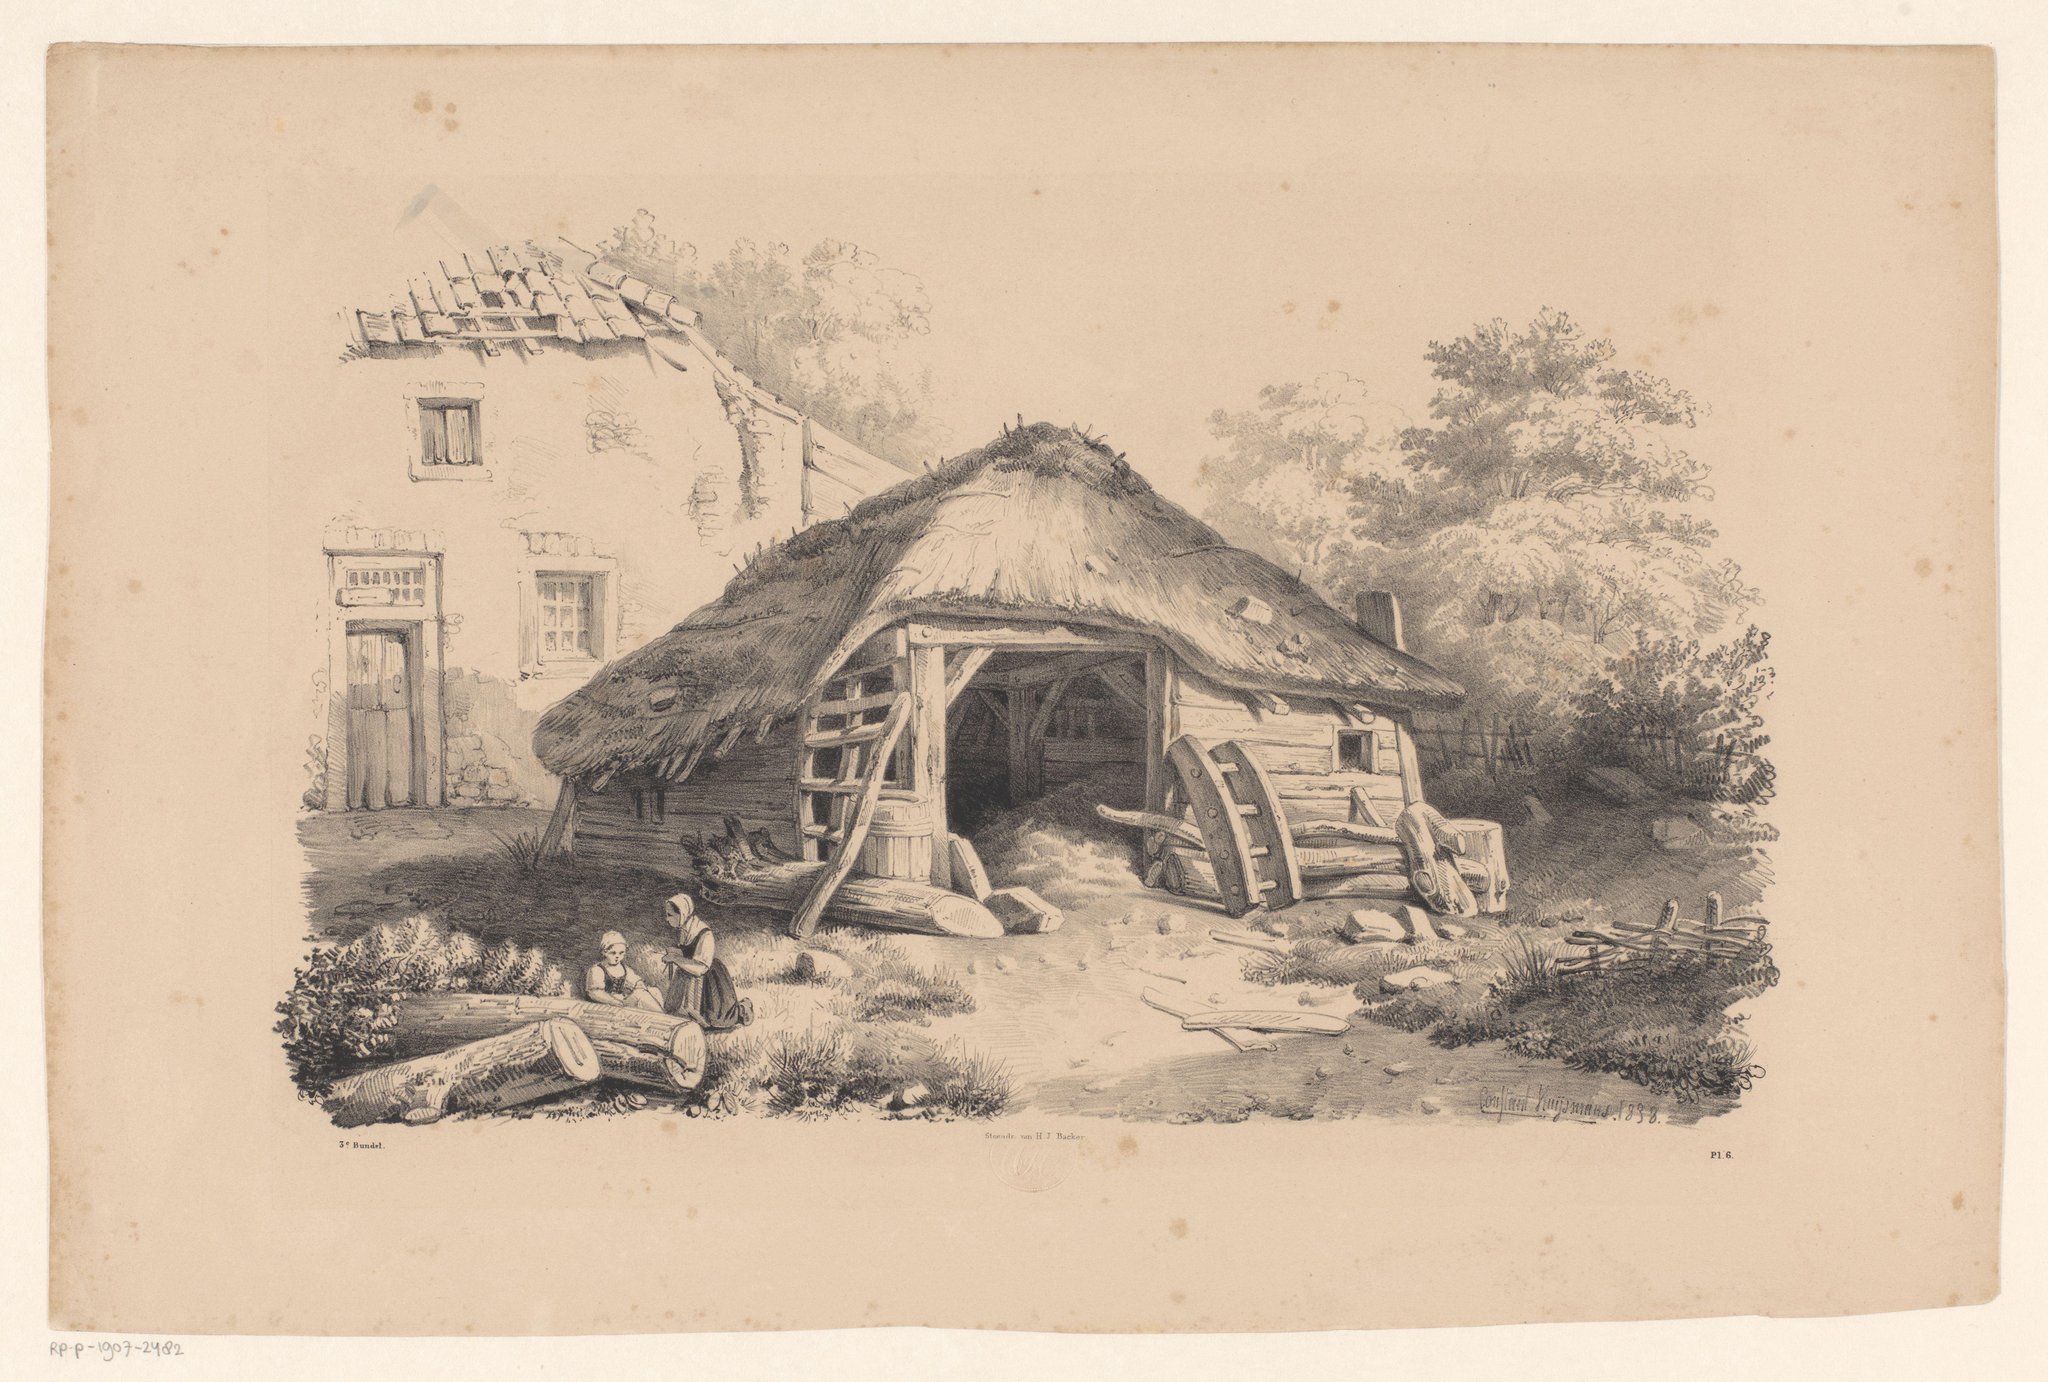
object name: print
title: Stal bij boerderij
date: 1838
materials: paper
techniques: lithograph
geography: dordrecht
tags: stall, stable, farm (building)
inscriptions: collector's mark: Lugt 2228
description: Deze prent maakt deel uit van een serie getiteld 'Het Landschap' door Constantinus Cornelis Huysmans. Deze serie werd door hem gebruikt als lesmateriaal op de Koninklijke Militaire Academie te Breda. Hij was docent handtekenen van 1837 tot 1866. Zie: W. van Giersbergen.